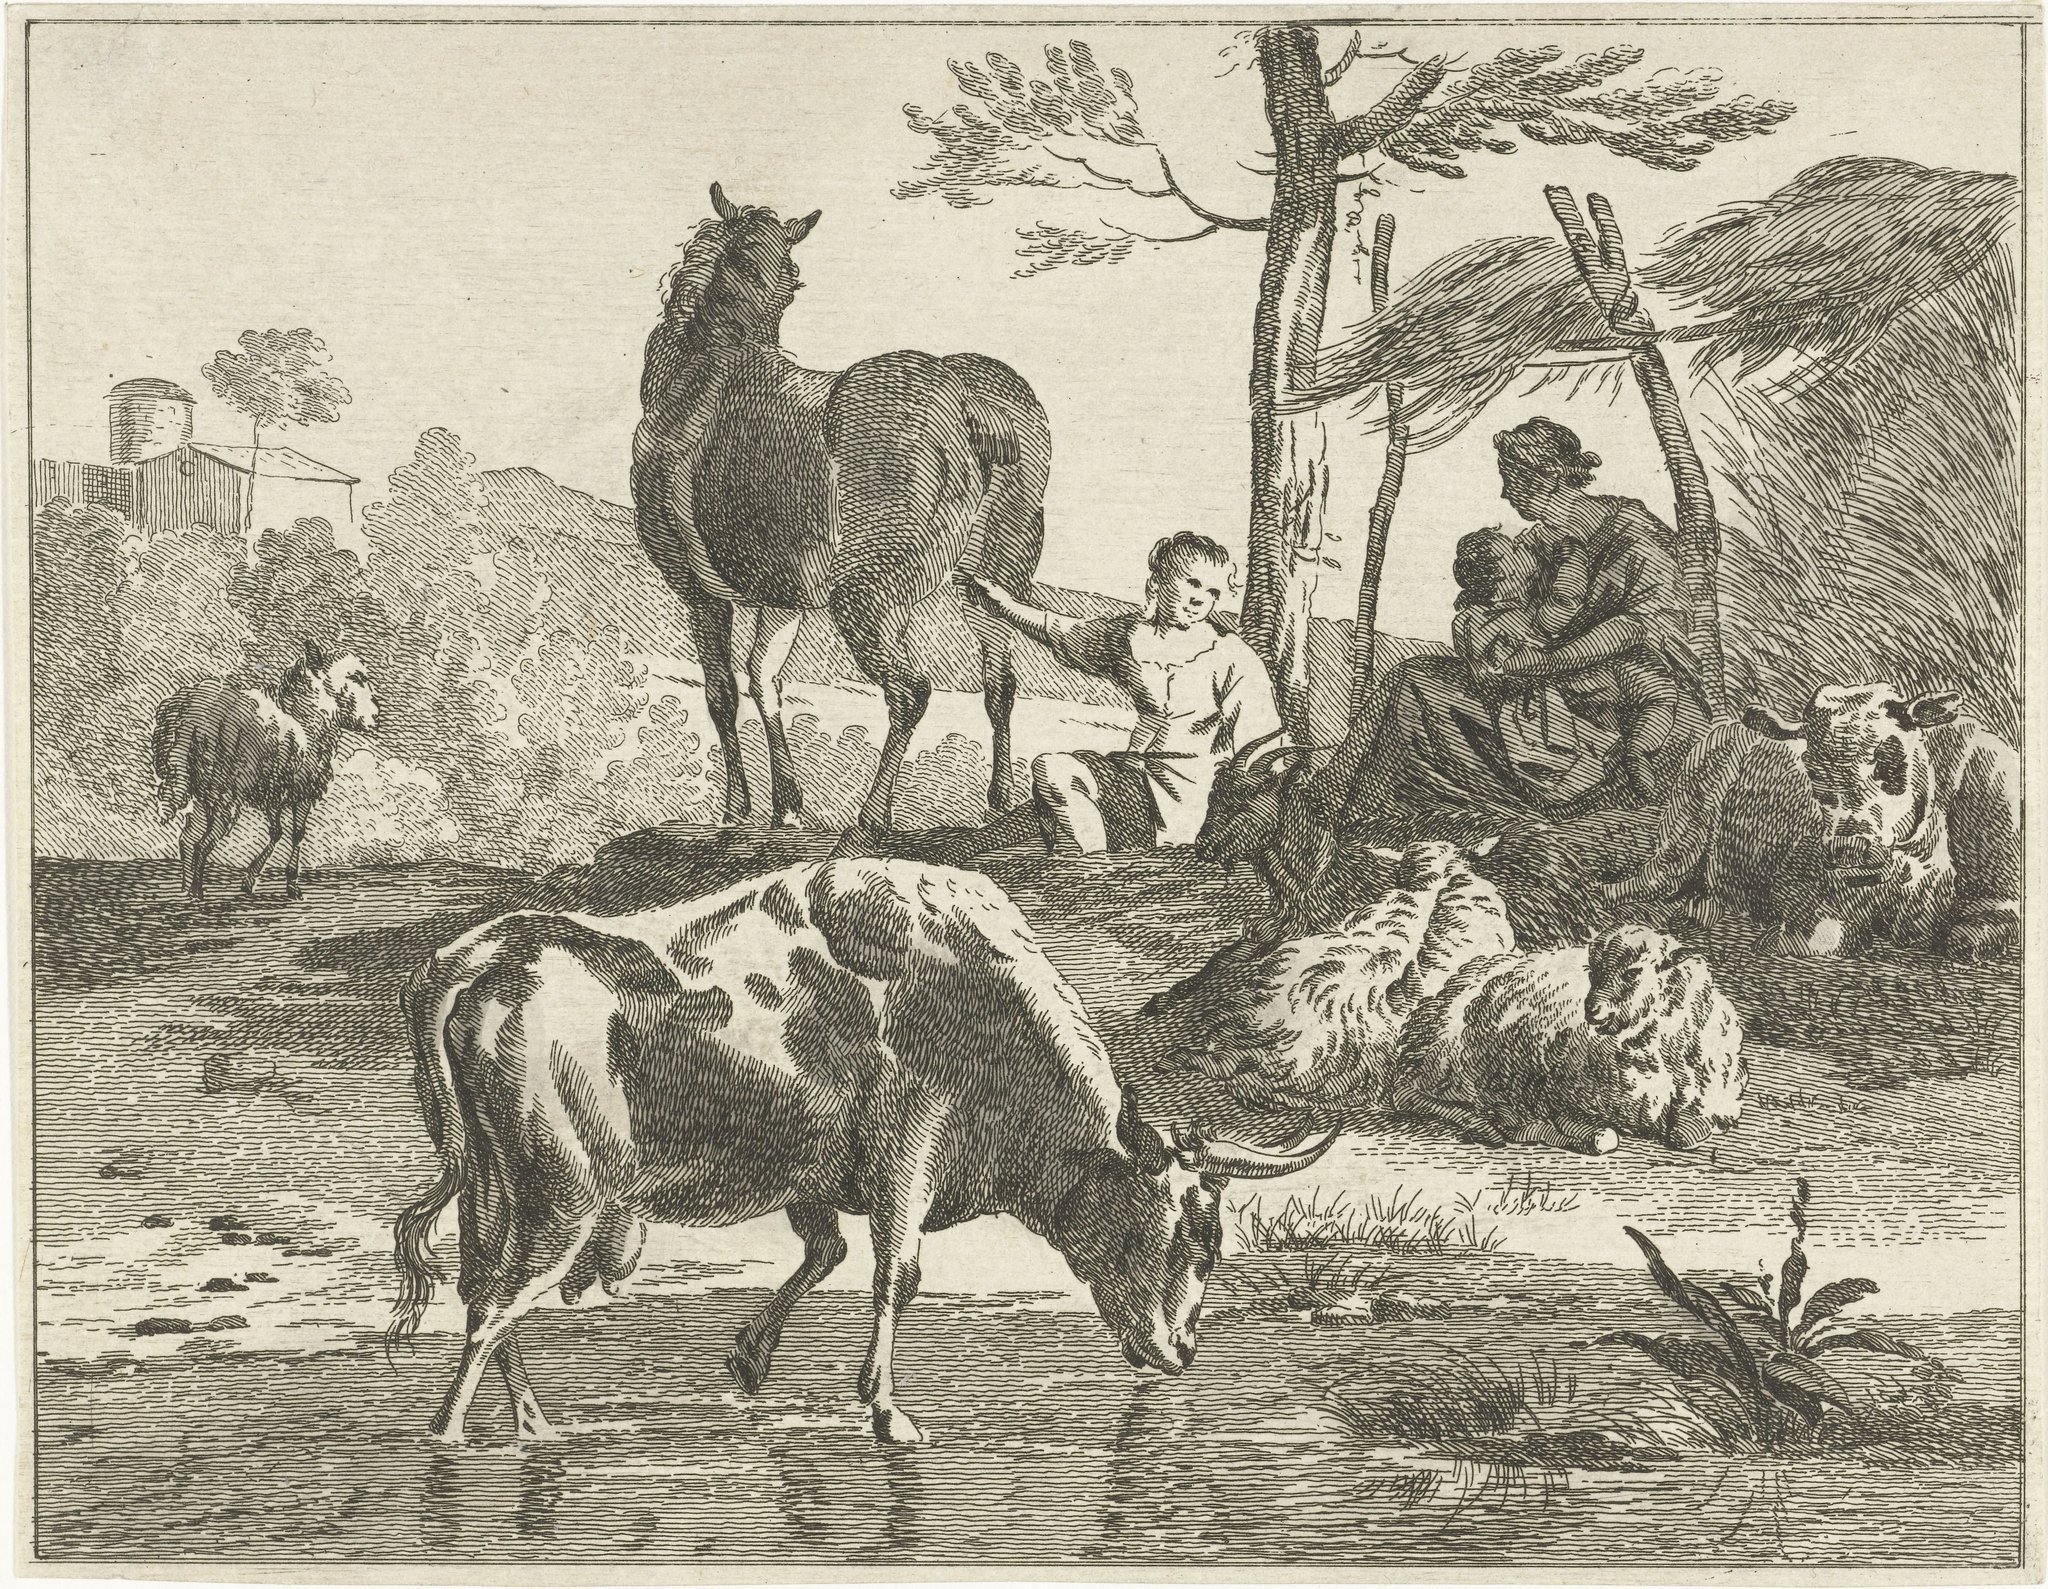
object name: print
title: Kudde vee in heuvelachtig landschap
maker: jan matthias cok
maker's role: draughtsman, print maker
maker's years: 1720-1771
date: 1735-1771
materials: paper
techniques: etching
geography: amsterdam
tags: herd, flock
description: Een kudde vee, bestaande uit twee koeien, een paard, drie schapen en een geit, bevindt zich in een heuvelachtig landschap. Rechts zit onder een rieten afdak een vrouw, die een kind de borst geeft, naast haar ziet men een vrouw, die met de rechterhand op het paard wijst.